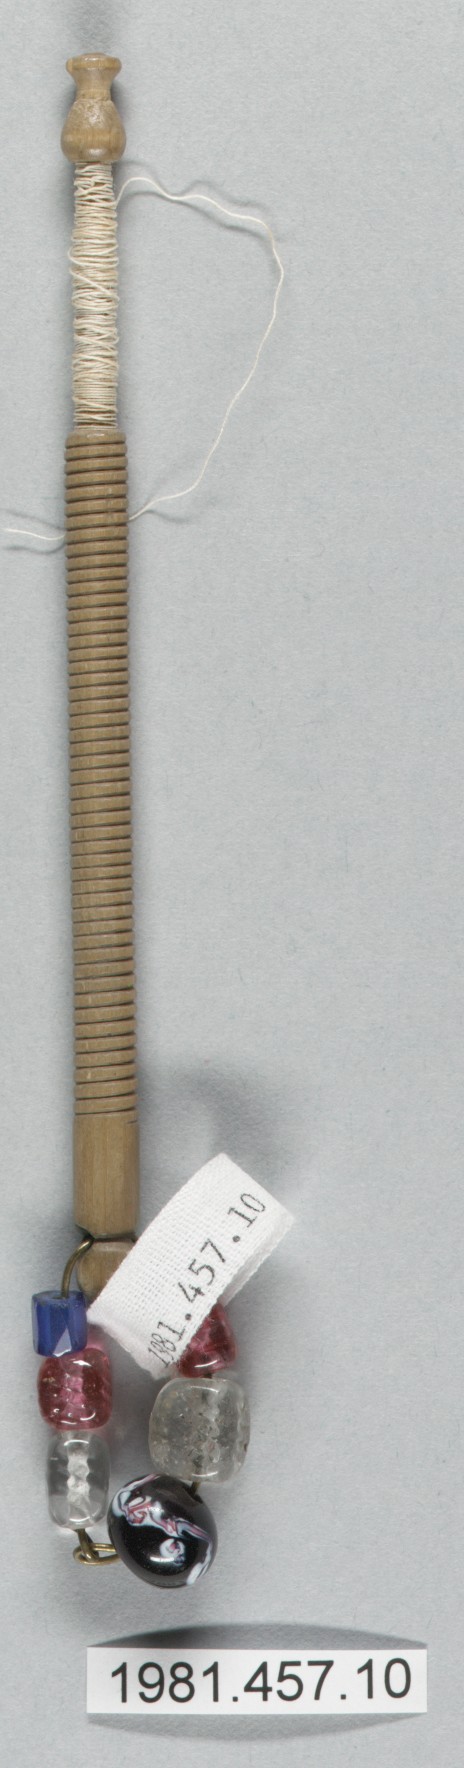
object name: bobbin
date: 1840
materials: wood